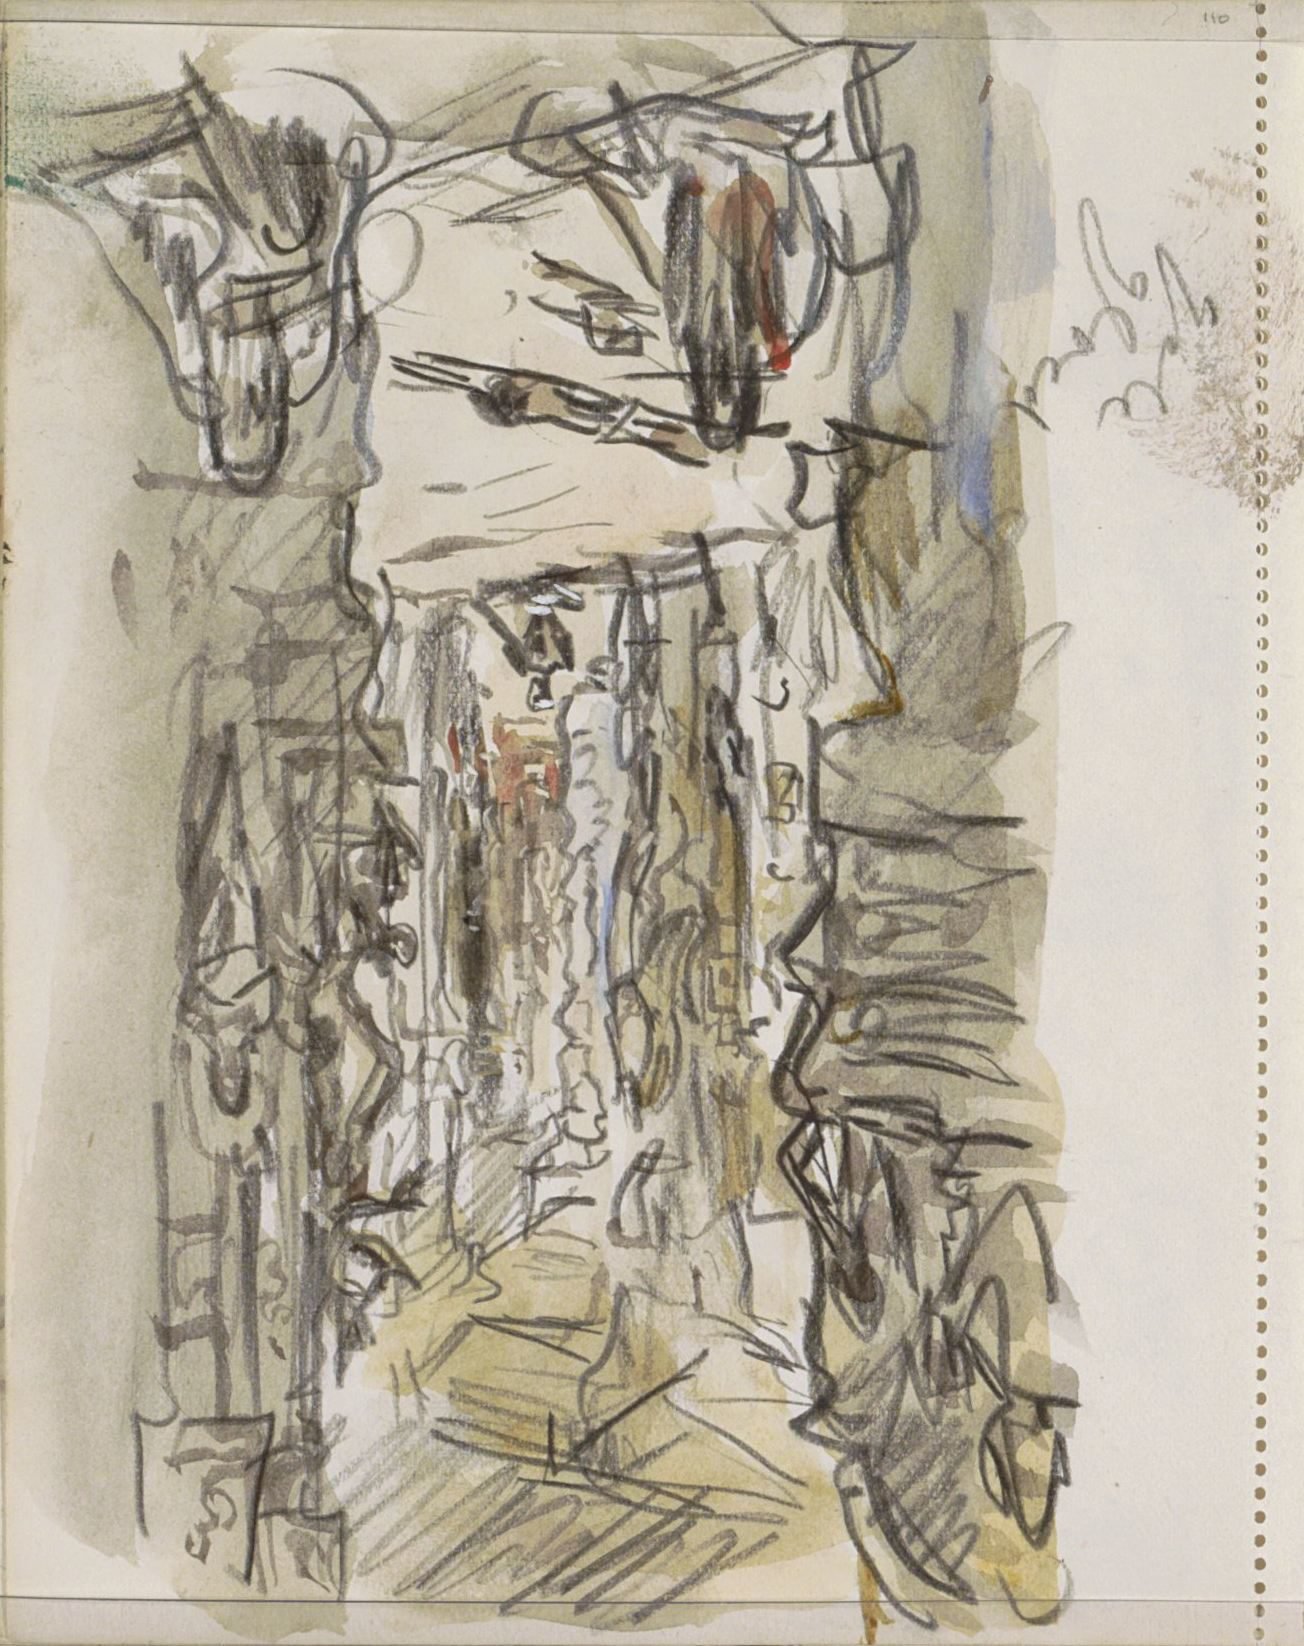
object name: sketchbook leaf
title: Indiërs in de Meenakshi Amman Tempel in Madurai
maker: marius bauer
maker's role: draughtsman, print maker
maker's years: 1867-1932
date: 1924-1925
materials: chalk, paper, watercolor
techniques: brush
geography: madurai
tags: temple, shrine ~ hinduism, buddhism, jainism, sitting figure, interior ~ representation of a building, asiatic races and peoples: indians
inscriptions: kleurnotitie, handgeschreven in potlood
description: Pagina 110 uit een schetsboek met 75 bladen.